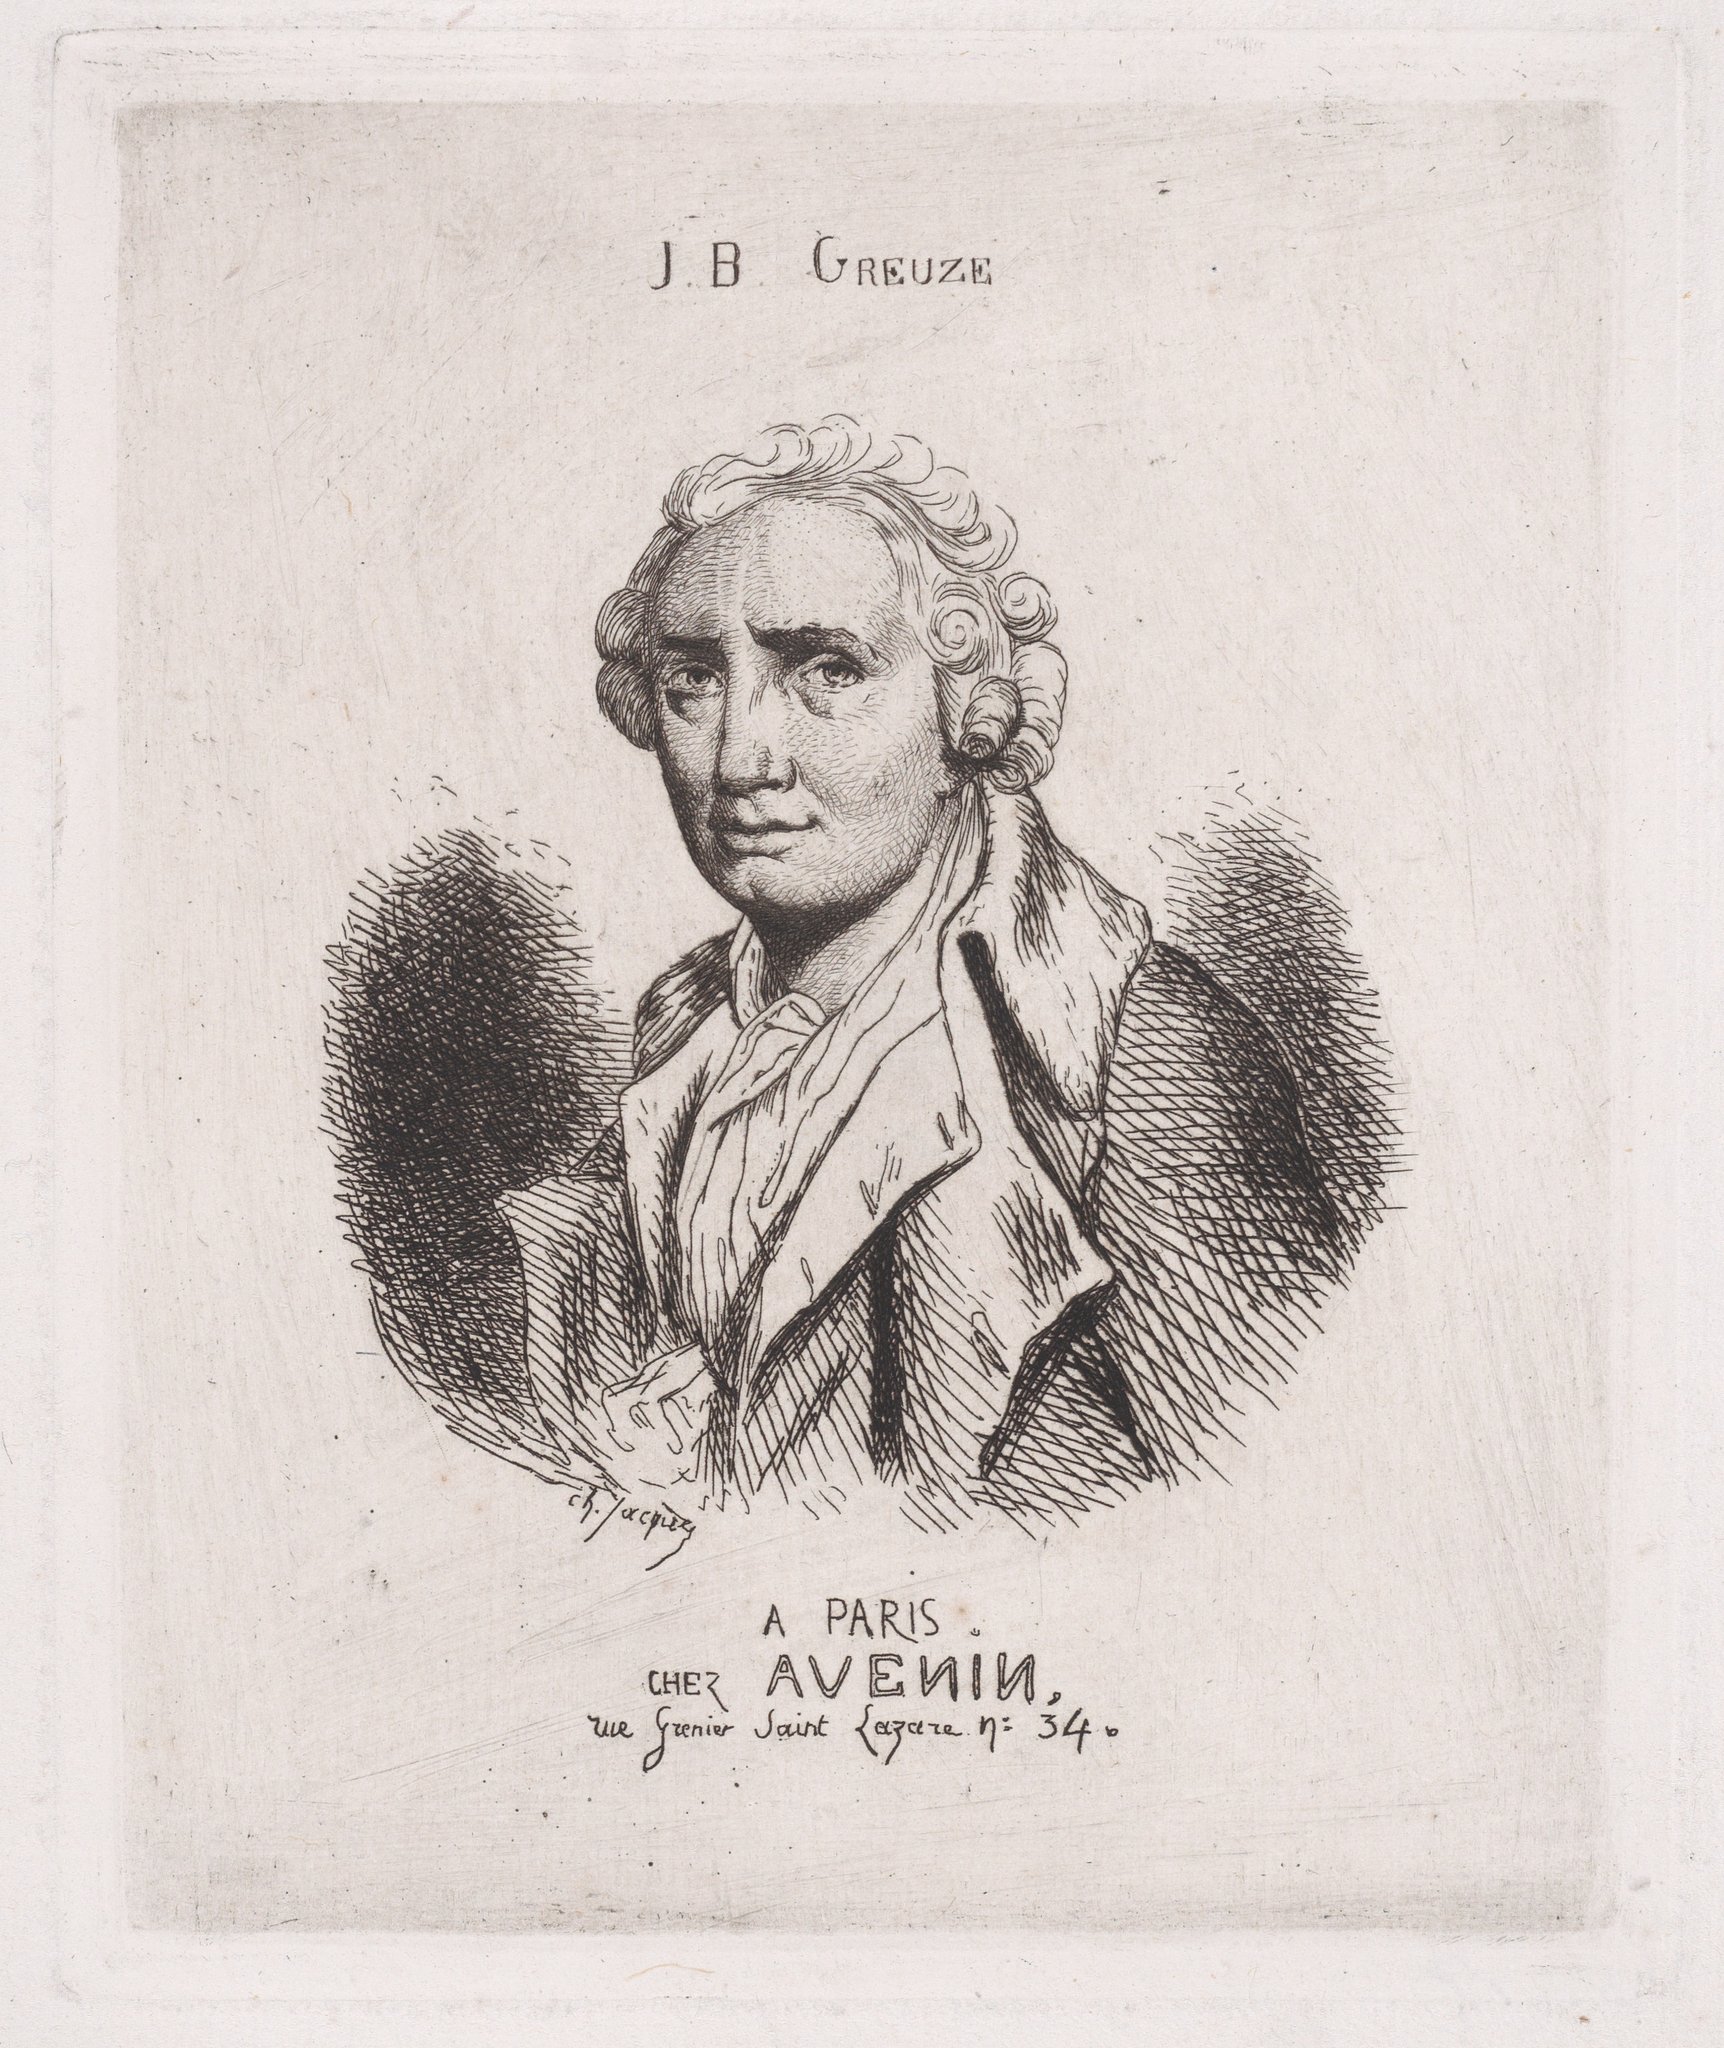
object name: print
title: Portrait of J.B. Greuze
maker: charles émile jacque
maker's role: artist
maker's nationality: french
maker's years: 1813-1894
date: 1801-1900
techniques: etching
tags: men,portraits,artists